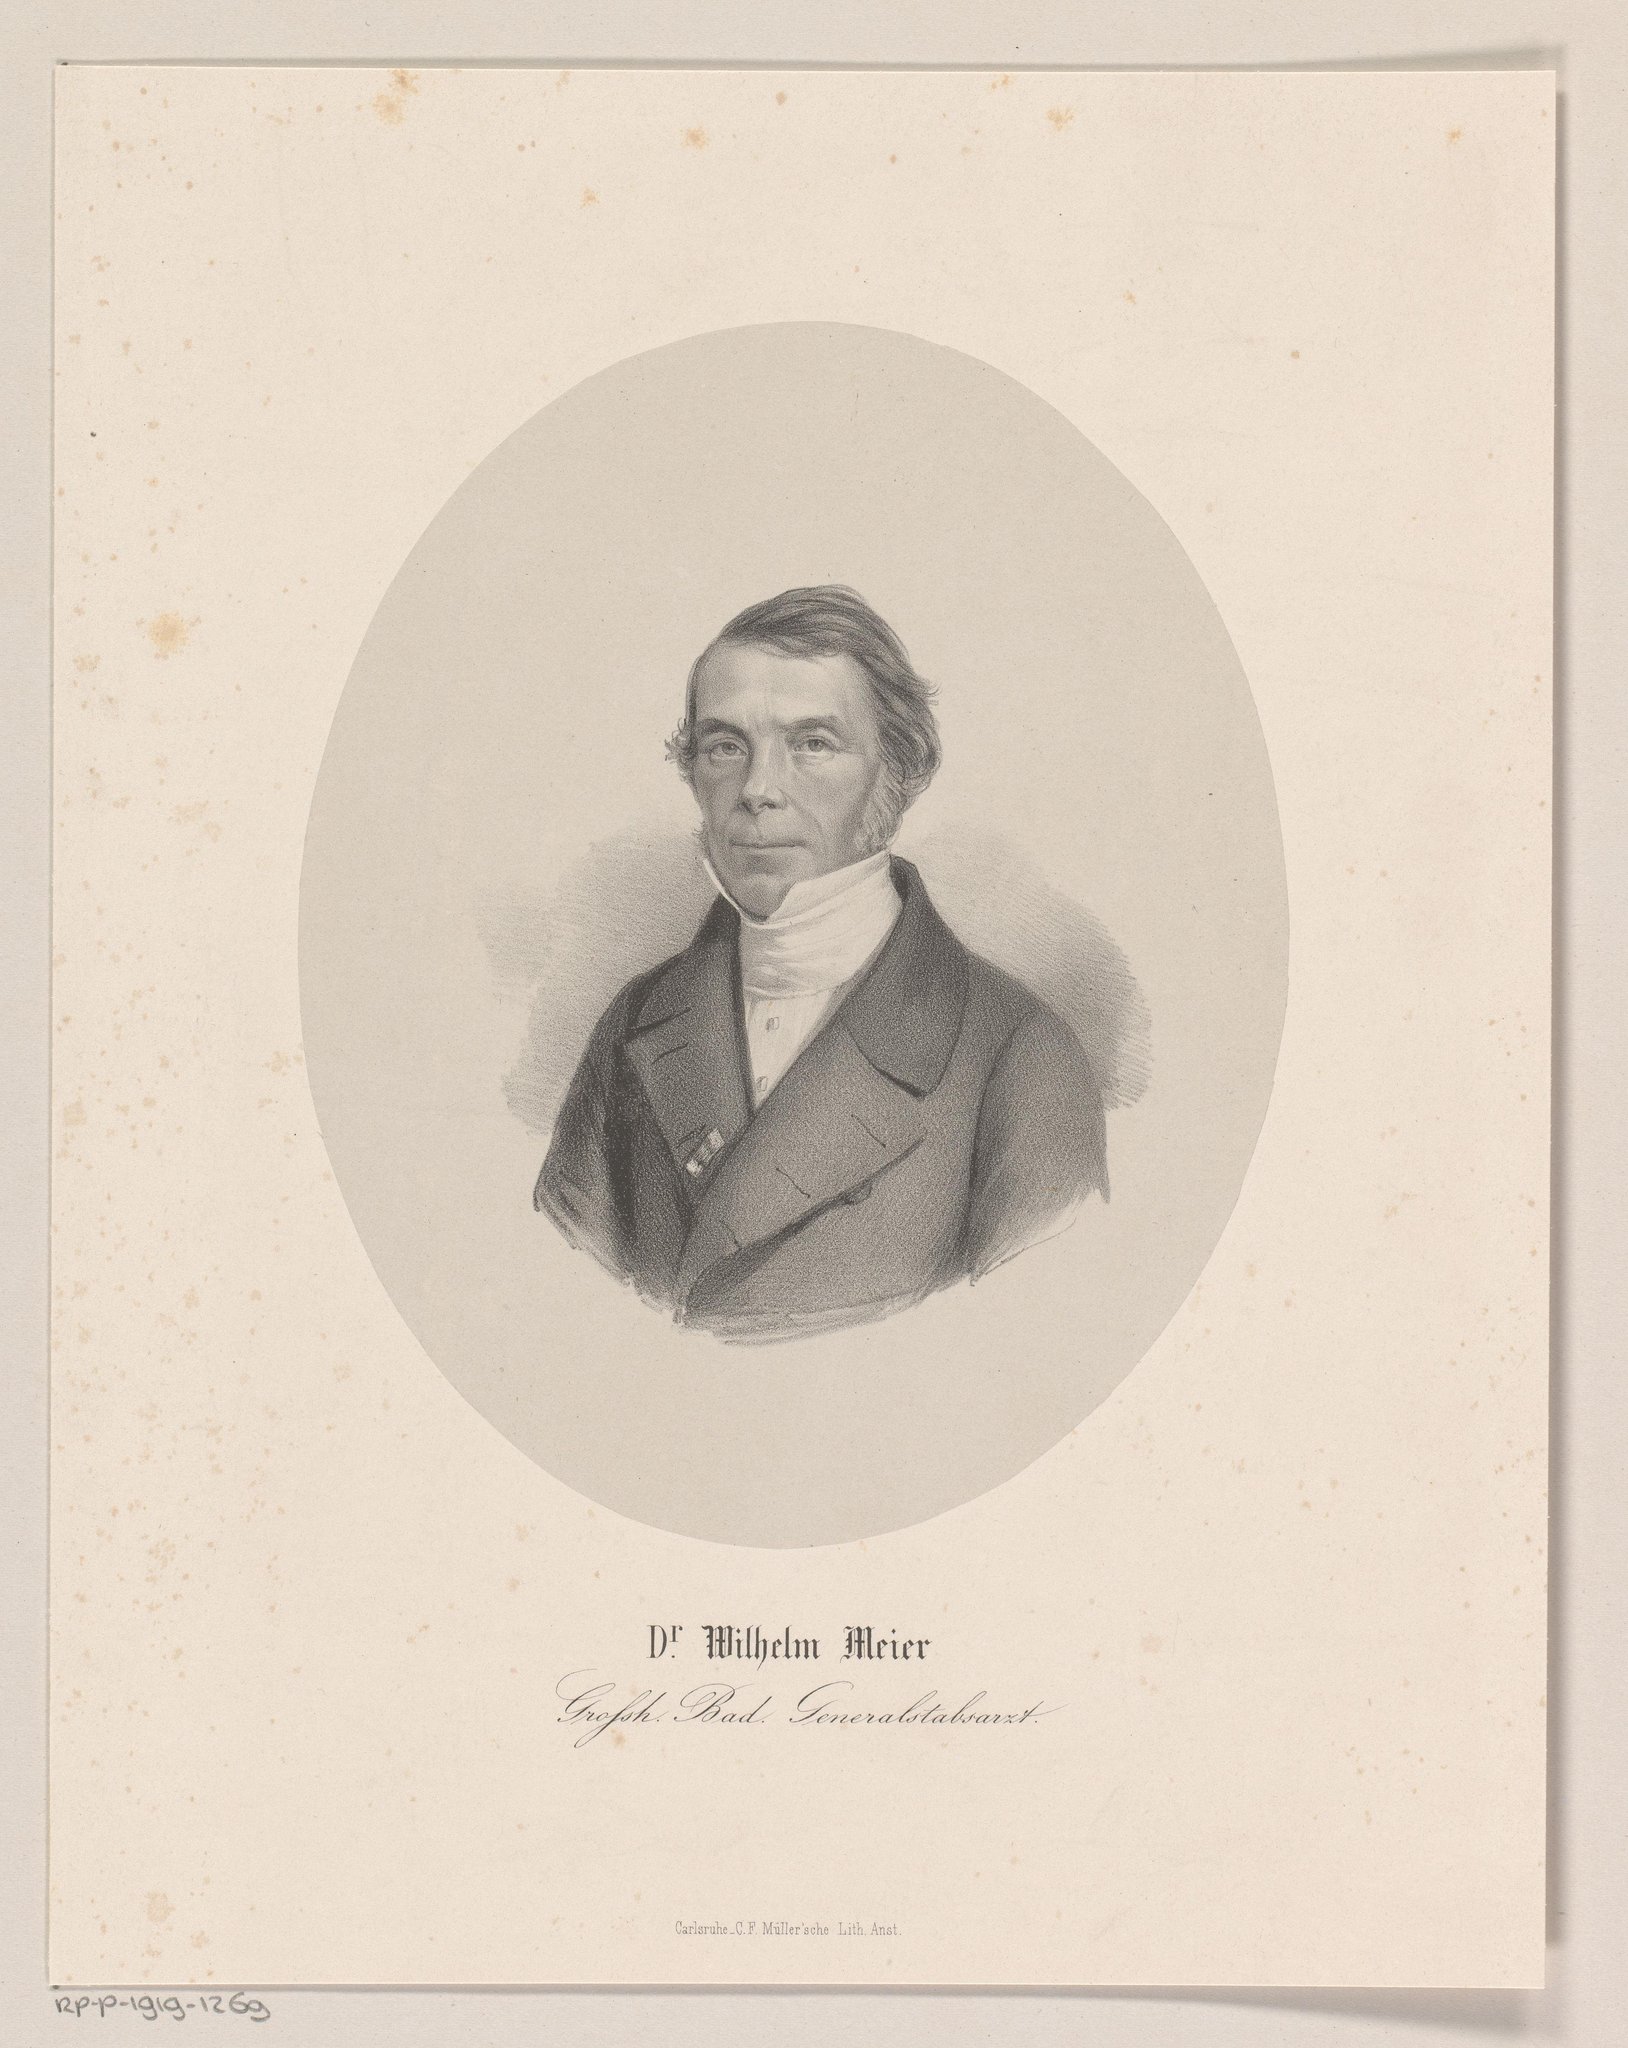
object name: print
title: Portret van Wilhelm Meier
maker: Anonymous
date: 1813-1900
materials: paper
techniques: lithograph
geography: karlsruhe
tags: historical persons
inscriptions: collector's mark: Lugt 2228